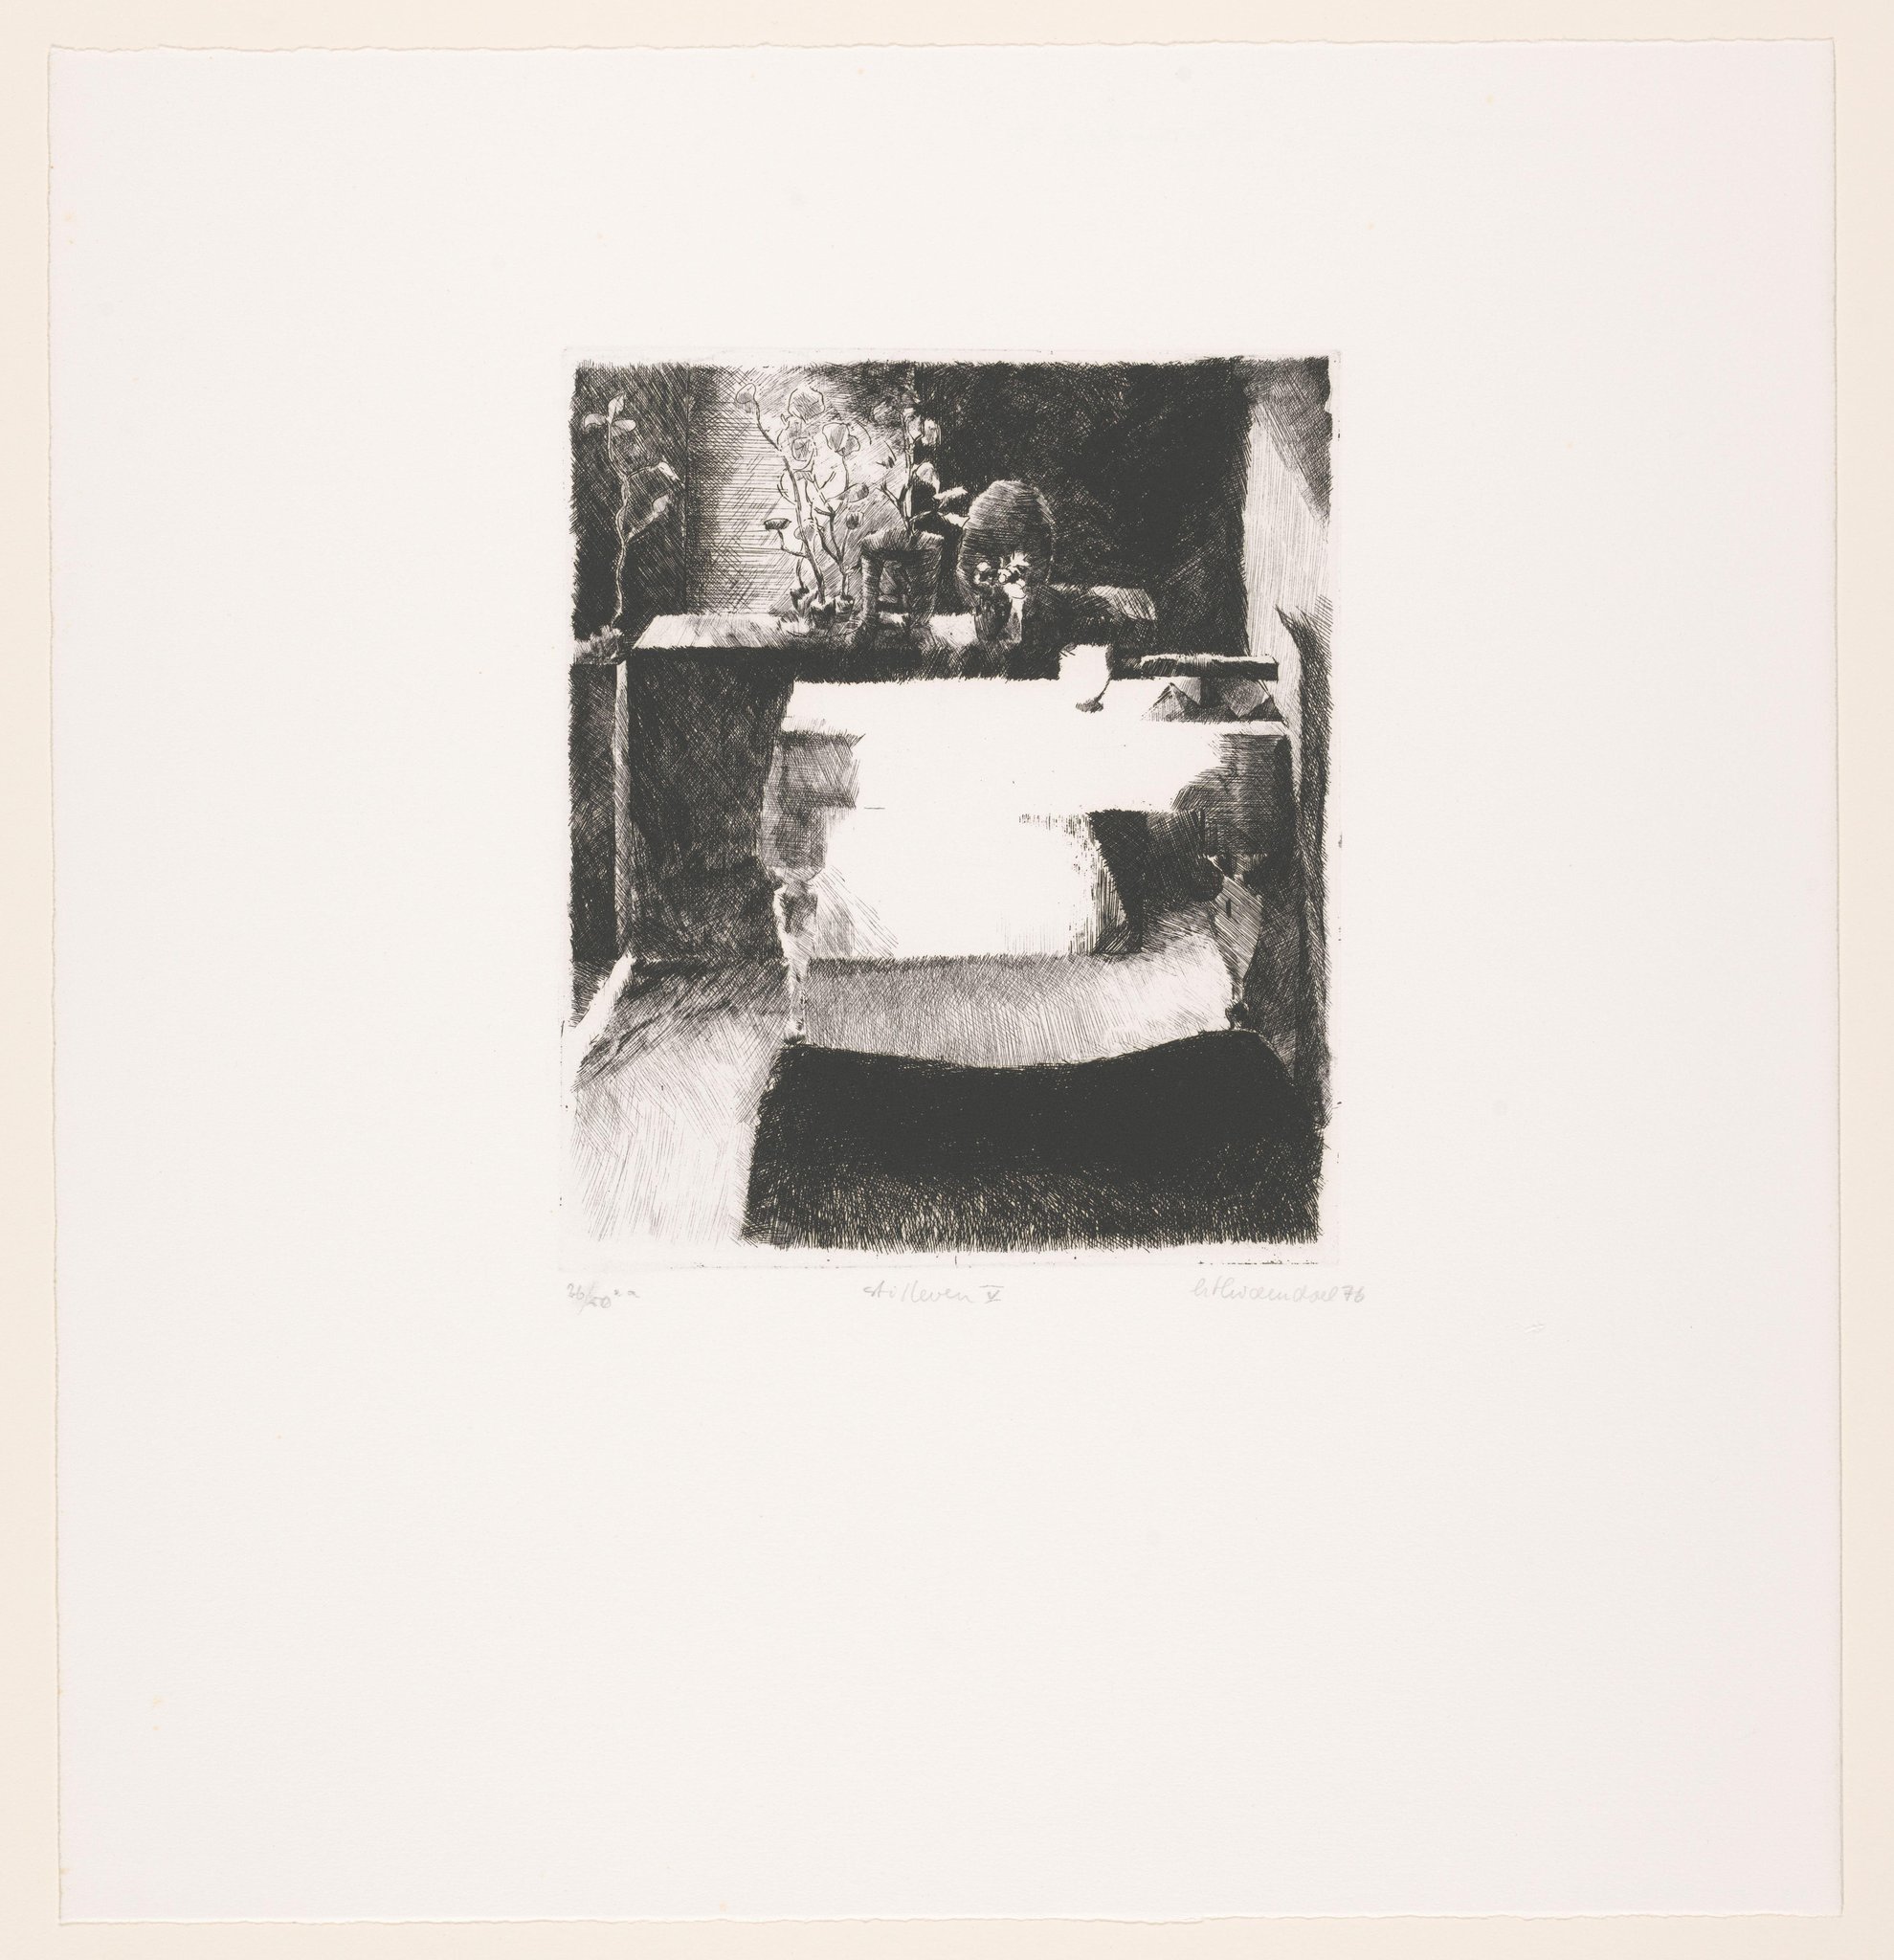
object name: print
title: Stilleven V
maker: lau heidendael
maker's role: print maker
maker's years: 1946-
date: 1976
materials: paper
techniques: etching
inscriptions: title: ‘stilleven V’, signature and date: ‘L Heidendael 76’, edition: ‘26/50 e.a.’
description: Schedel en orchideeën op kast in het halfduister.